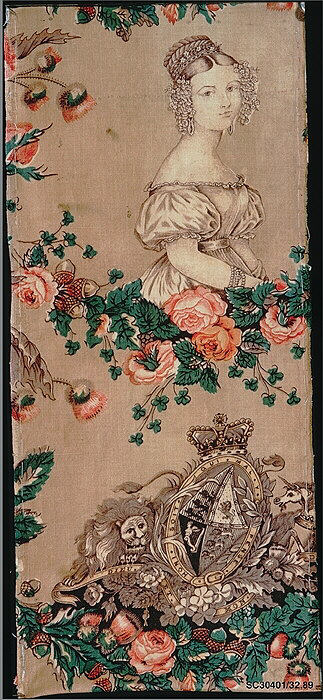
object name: fragment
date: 1837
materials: cotton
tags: roses,coat of arms,queen victoria